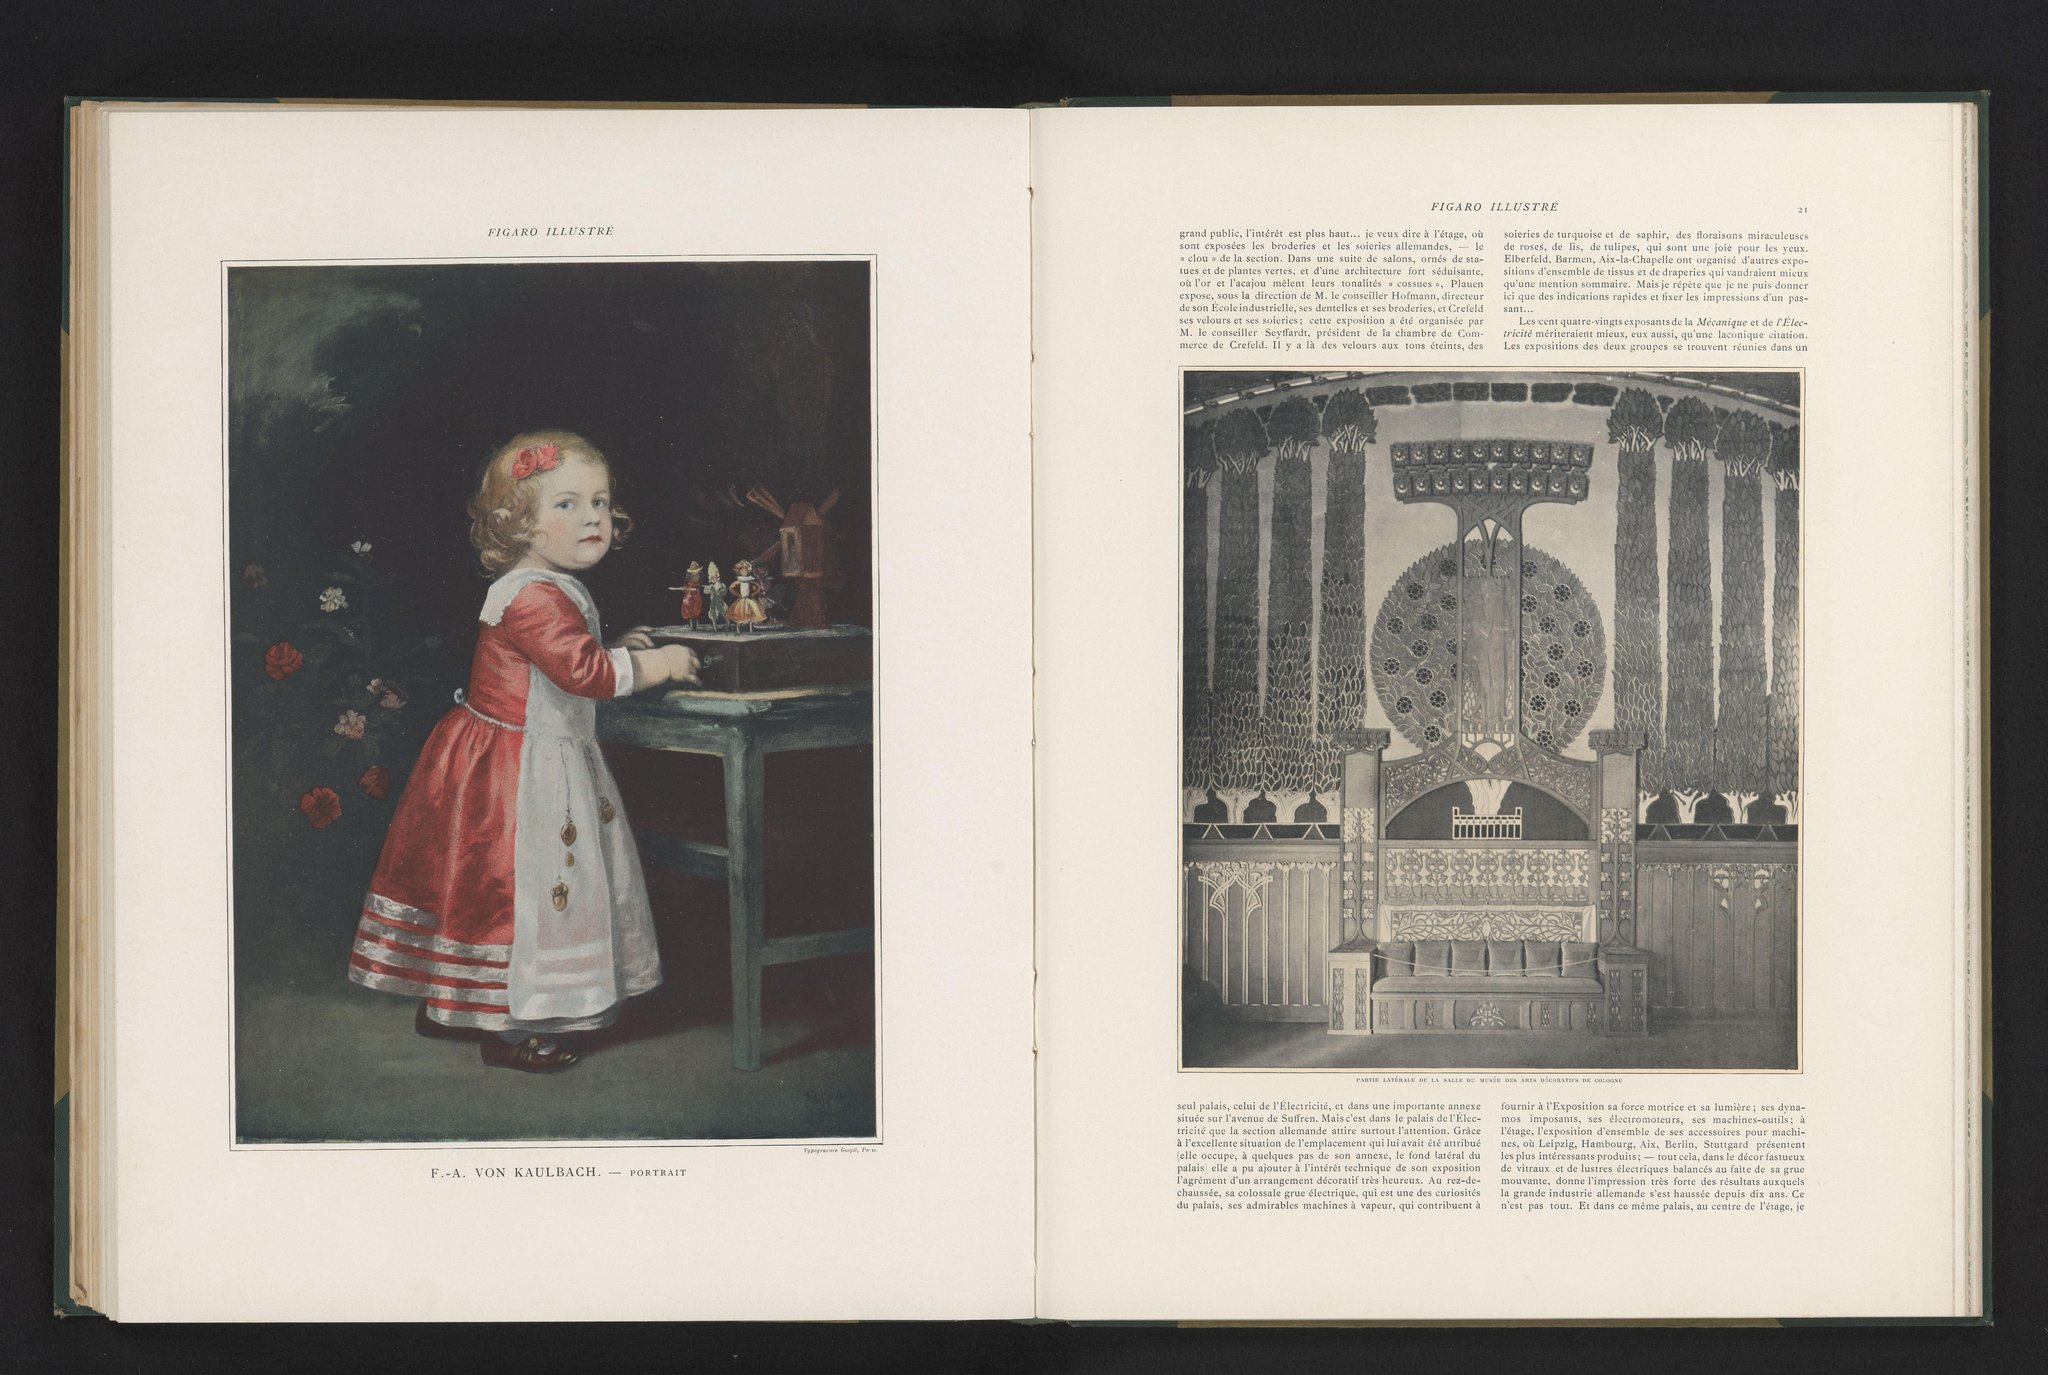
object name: page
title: Portrait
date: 1885-1901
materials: paper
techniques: four-color autotype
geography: paris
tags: historical persons - bb - woman, girl (child between toddler and youth)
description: Prent tegenover pagina 21 van Figaro-Illustré (Octobre 1900).